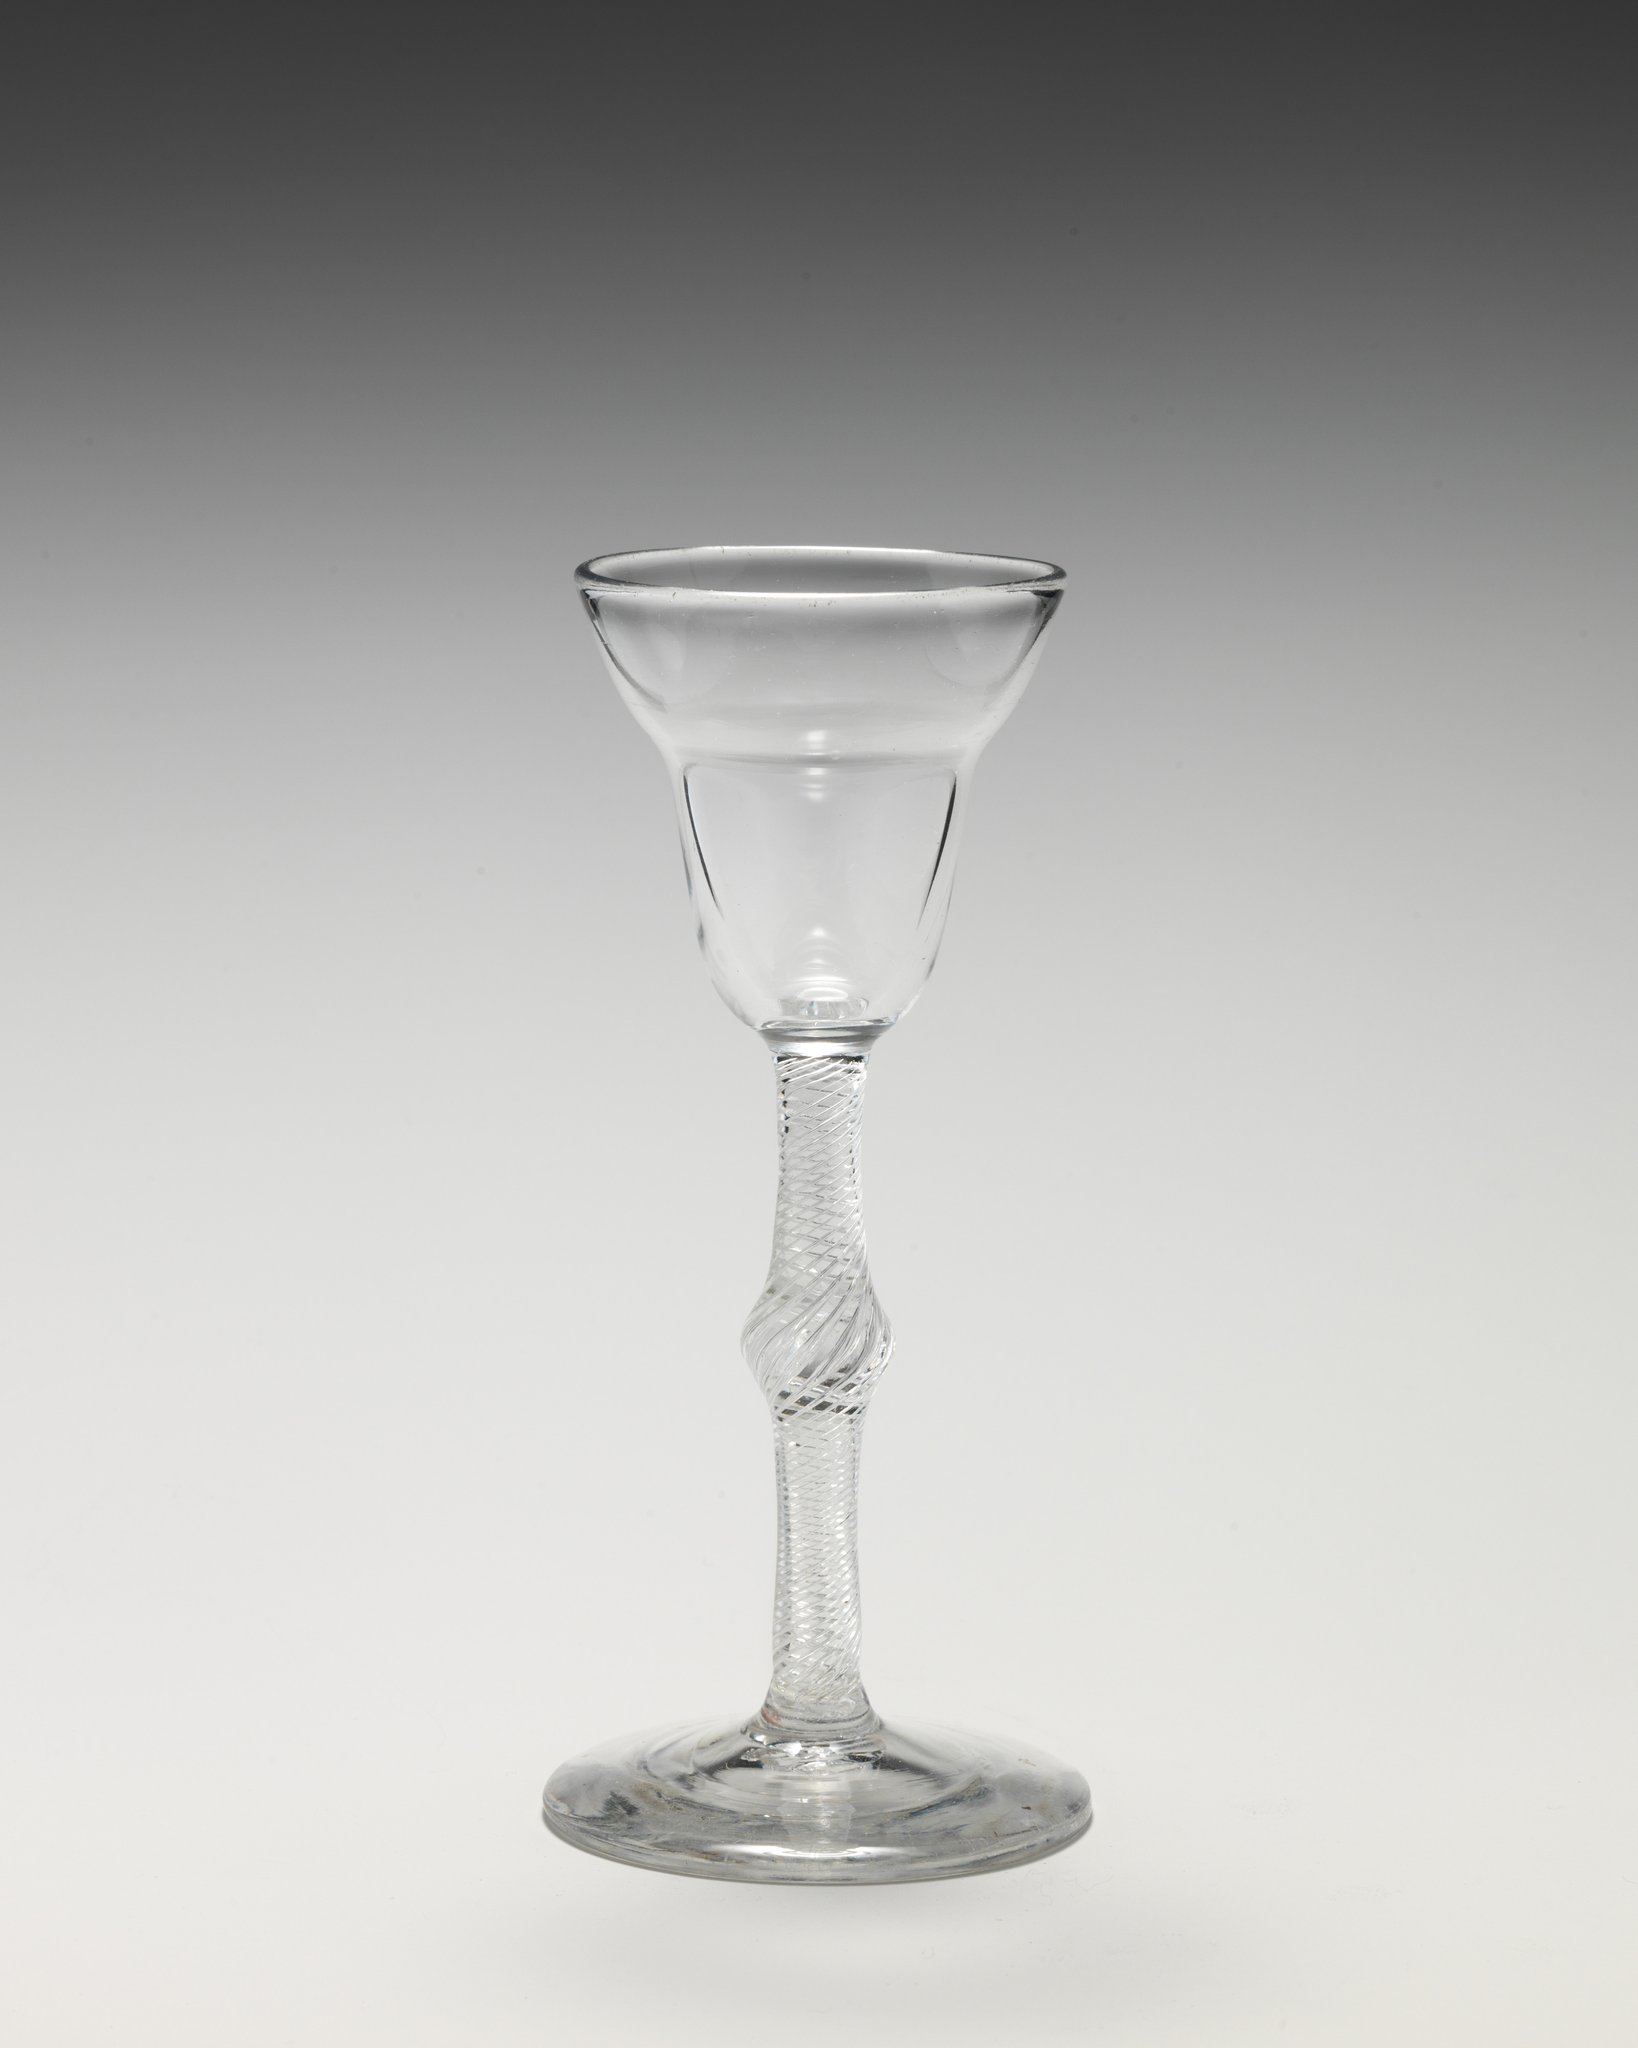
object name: wineglass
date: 1730-1770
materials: glass